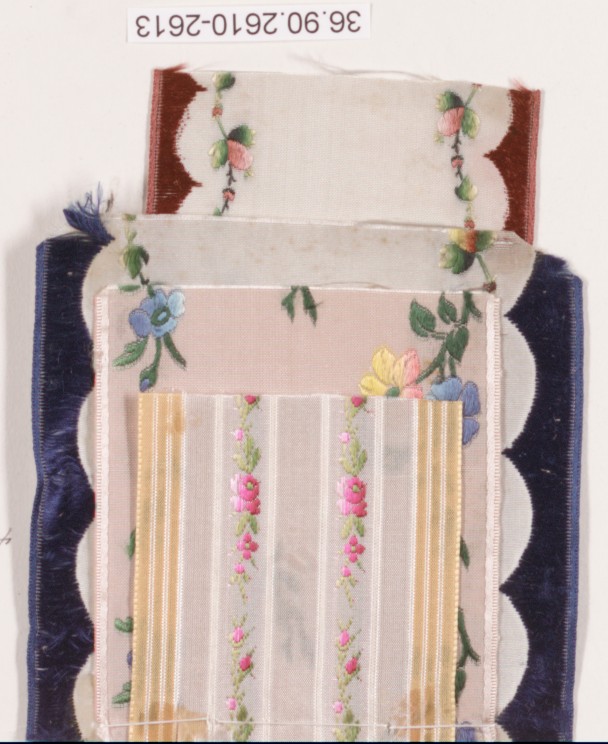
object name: ribbon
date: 1801-1900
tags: flowers